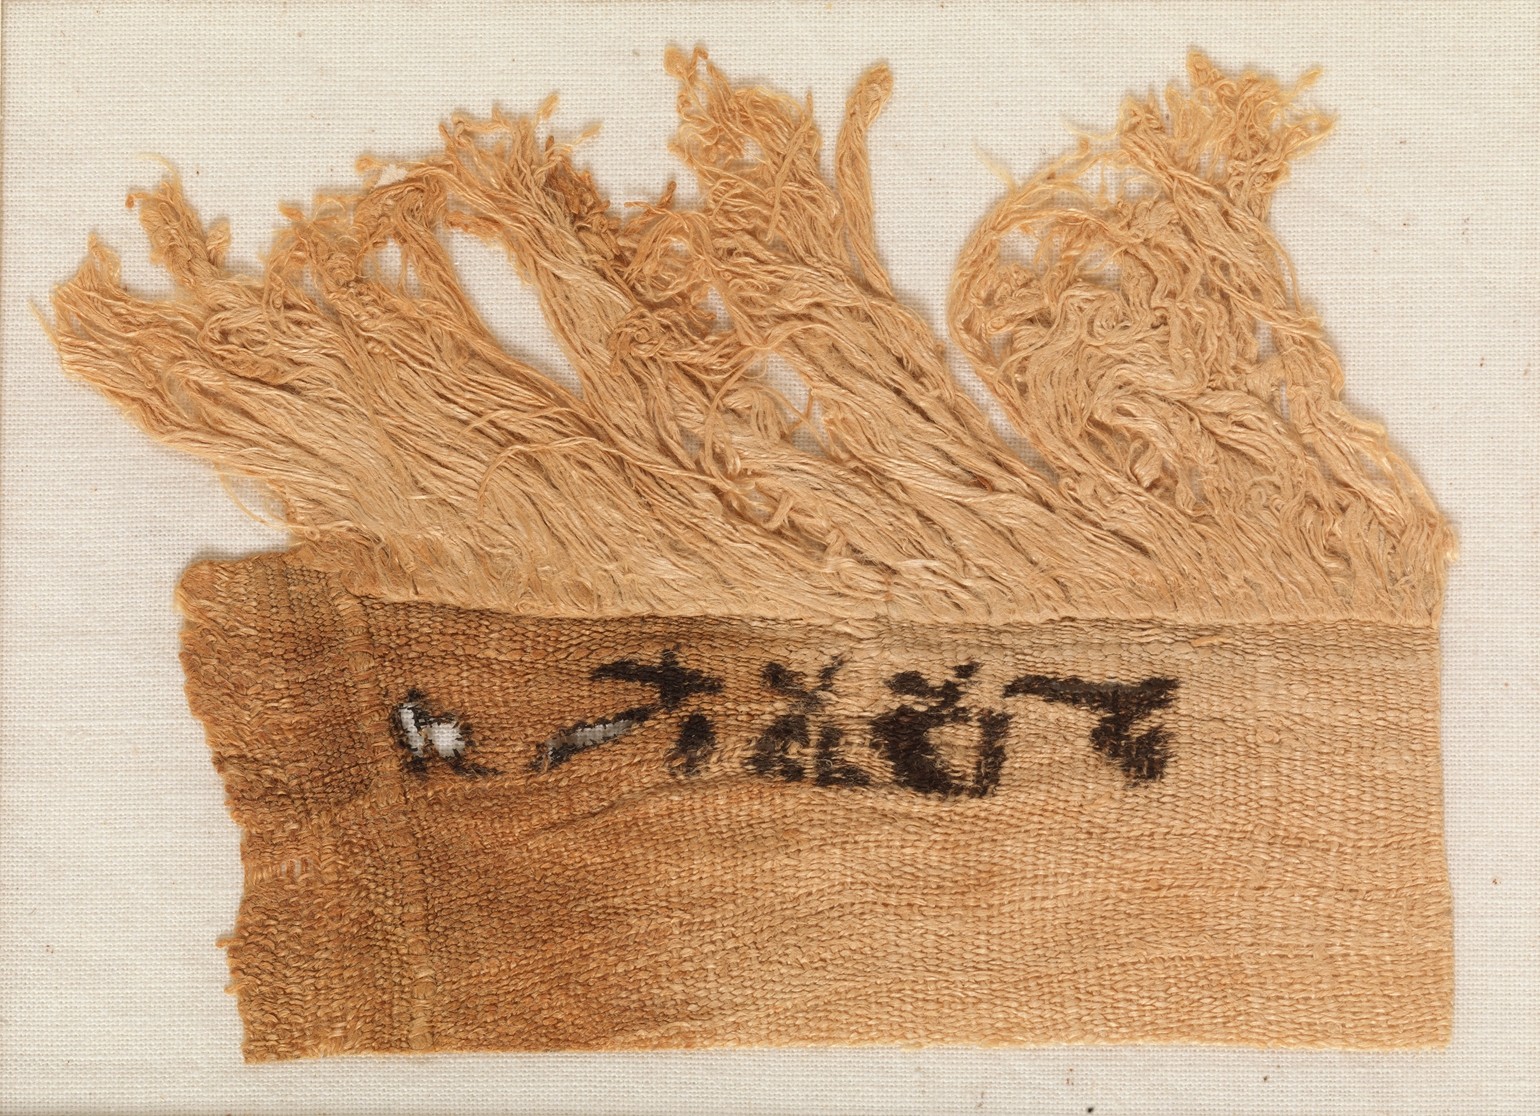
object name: linen mark, wah, 20. 3. 203ttt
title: Linen mark, Wah, 20.3.203ttt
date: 1981-1975 BCE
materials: linen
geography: egypt